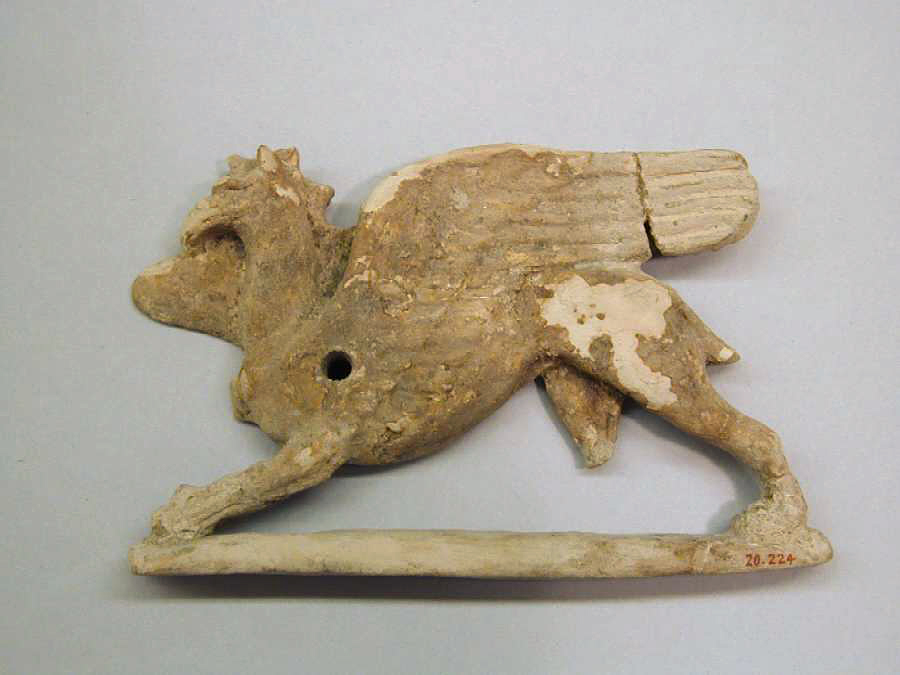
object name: relief of a griffin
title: Terracotta appliqué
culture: greek, south italian, tarentine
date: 300-201 BCE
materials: terracotta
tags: griffins